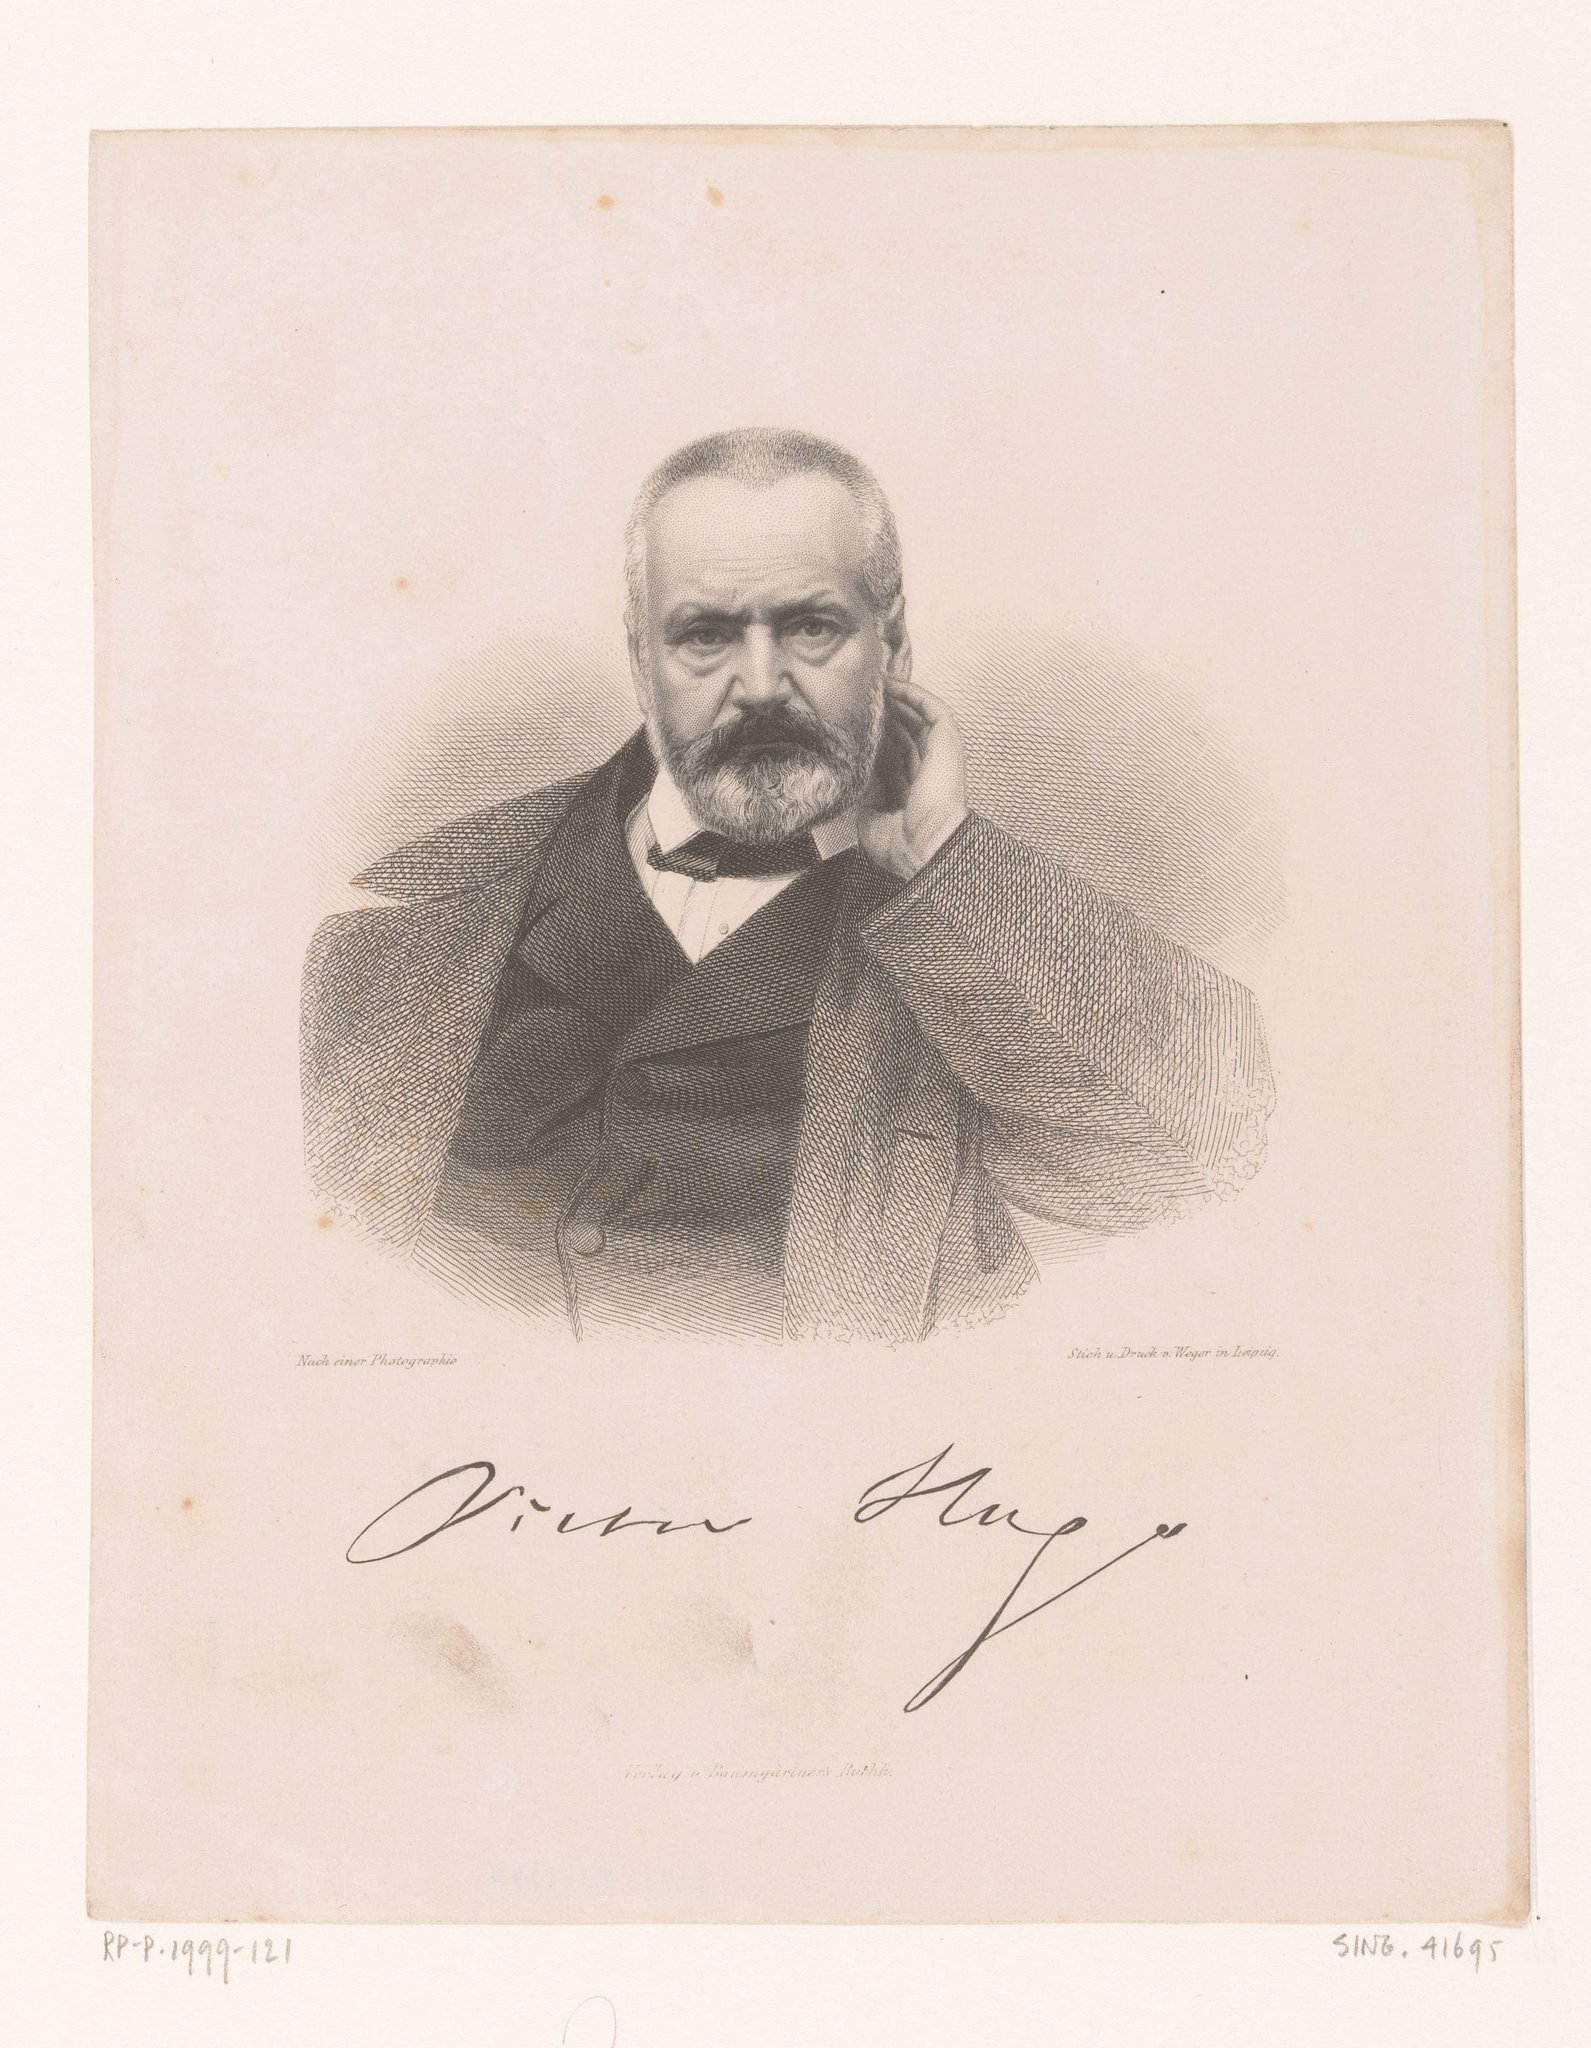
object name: print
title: Portret van Victor Hugo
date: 1849-1892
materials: paper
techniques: engraving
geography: leipzig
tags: paris, victor hugo, historical persons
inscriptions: collector's mark: Lugt 2760, collector's mark: ‘Franz Radestock’, collector's mark: Lugt 2228